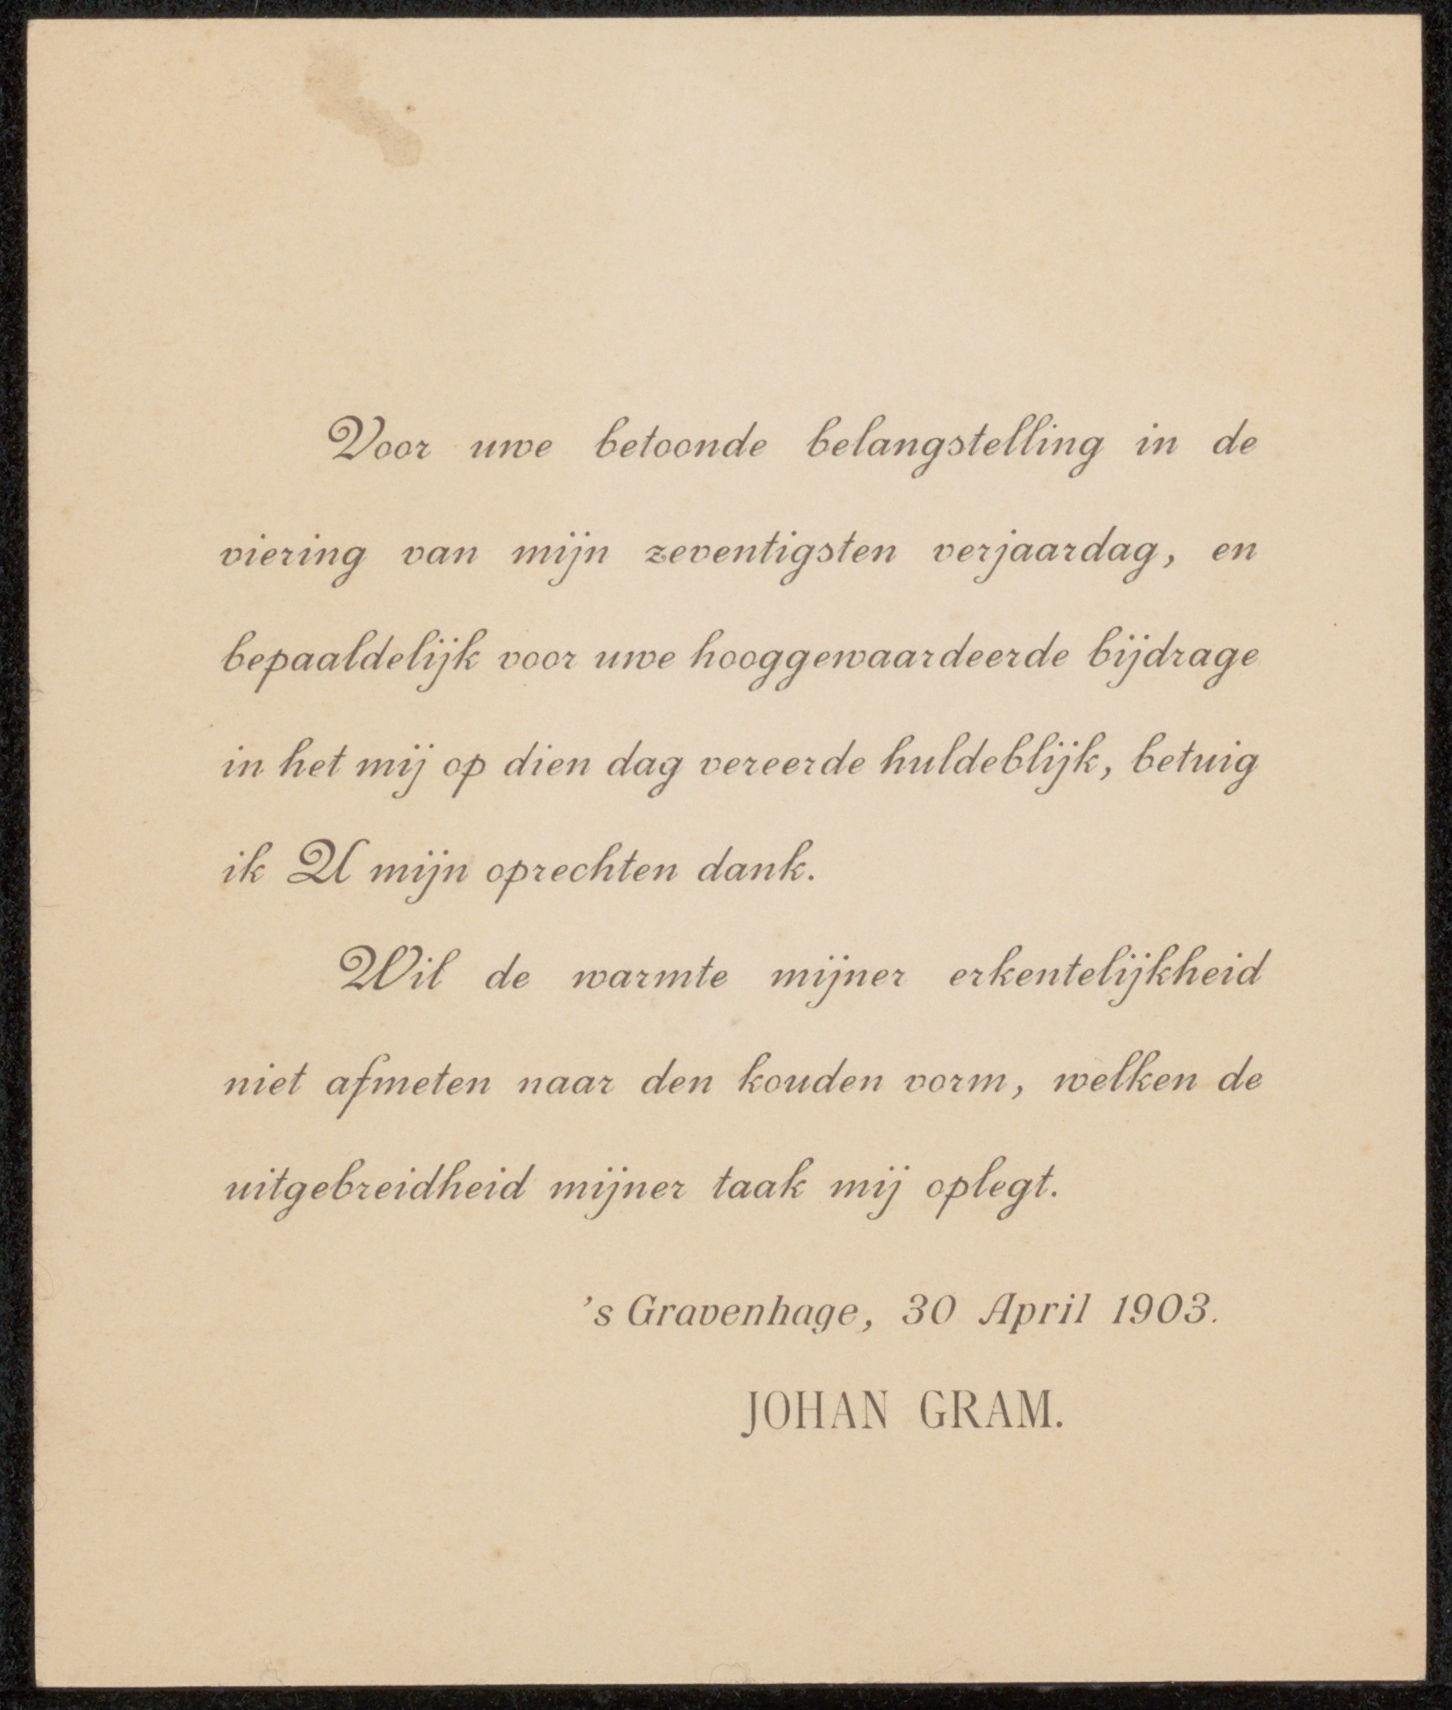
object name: letter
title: Brief aan Philip Zilcken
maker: johan gram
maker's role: kunstcriticus, letterkundige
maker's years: 1833-1914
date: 1903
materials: cardboard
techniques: printing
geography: the hague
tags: painter, draughtsman, philip zilcken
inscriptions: collector's mark: ‘RPK’